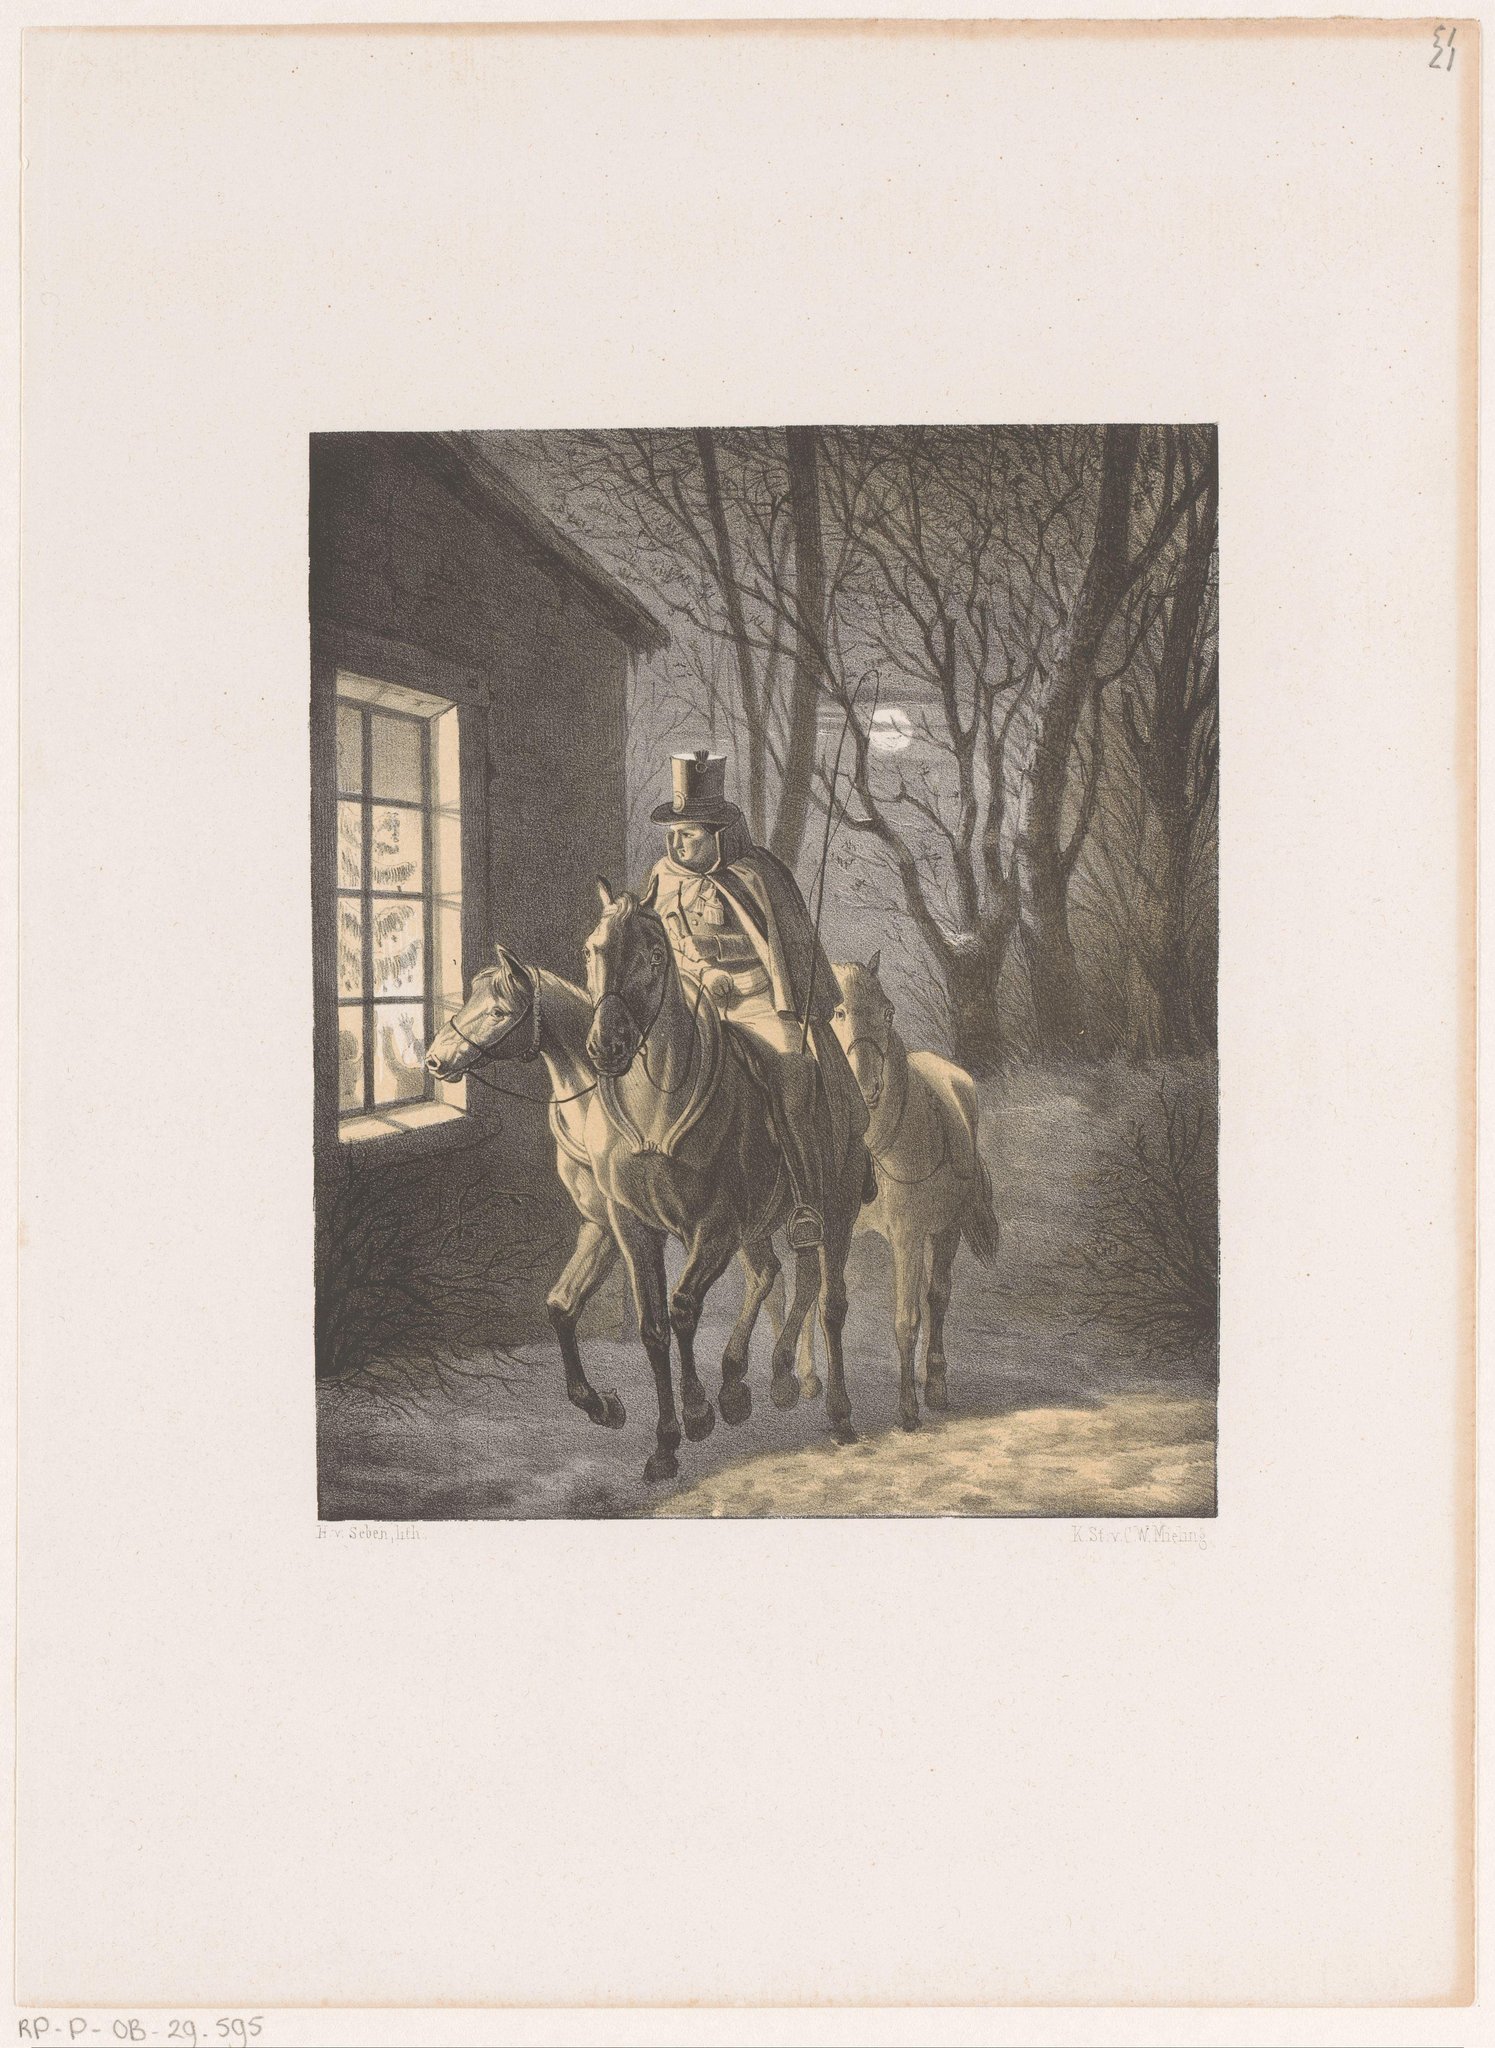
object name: print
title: Man te paard rijdt langs huis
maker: henri van seben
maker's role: print maker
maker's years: 1825-1913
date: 1847-1865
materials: paper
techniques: tone lithography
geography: the hague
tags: riding a horse, ass, or mule; rider, horseman, christmas tree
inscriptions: collector's mark: Lugt 2228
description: Een man te paard rijdt in de nacht langs een huis in een besneeuwd landschap. Door het venster ziet hij kinderen rond de kerstboom zitten. Achter de man lopen twee paarden.